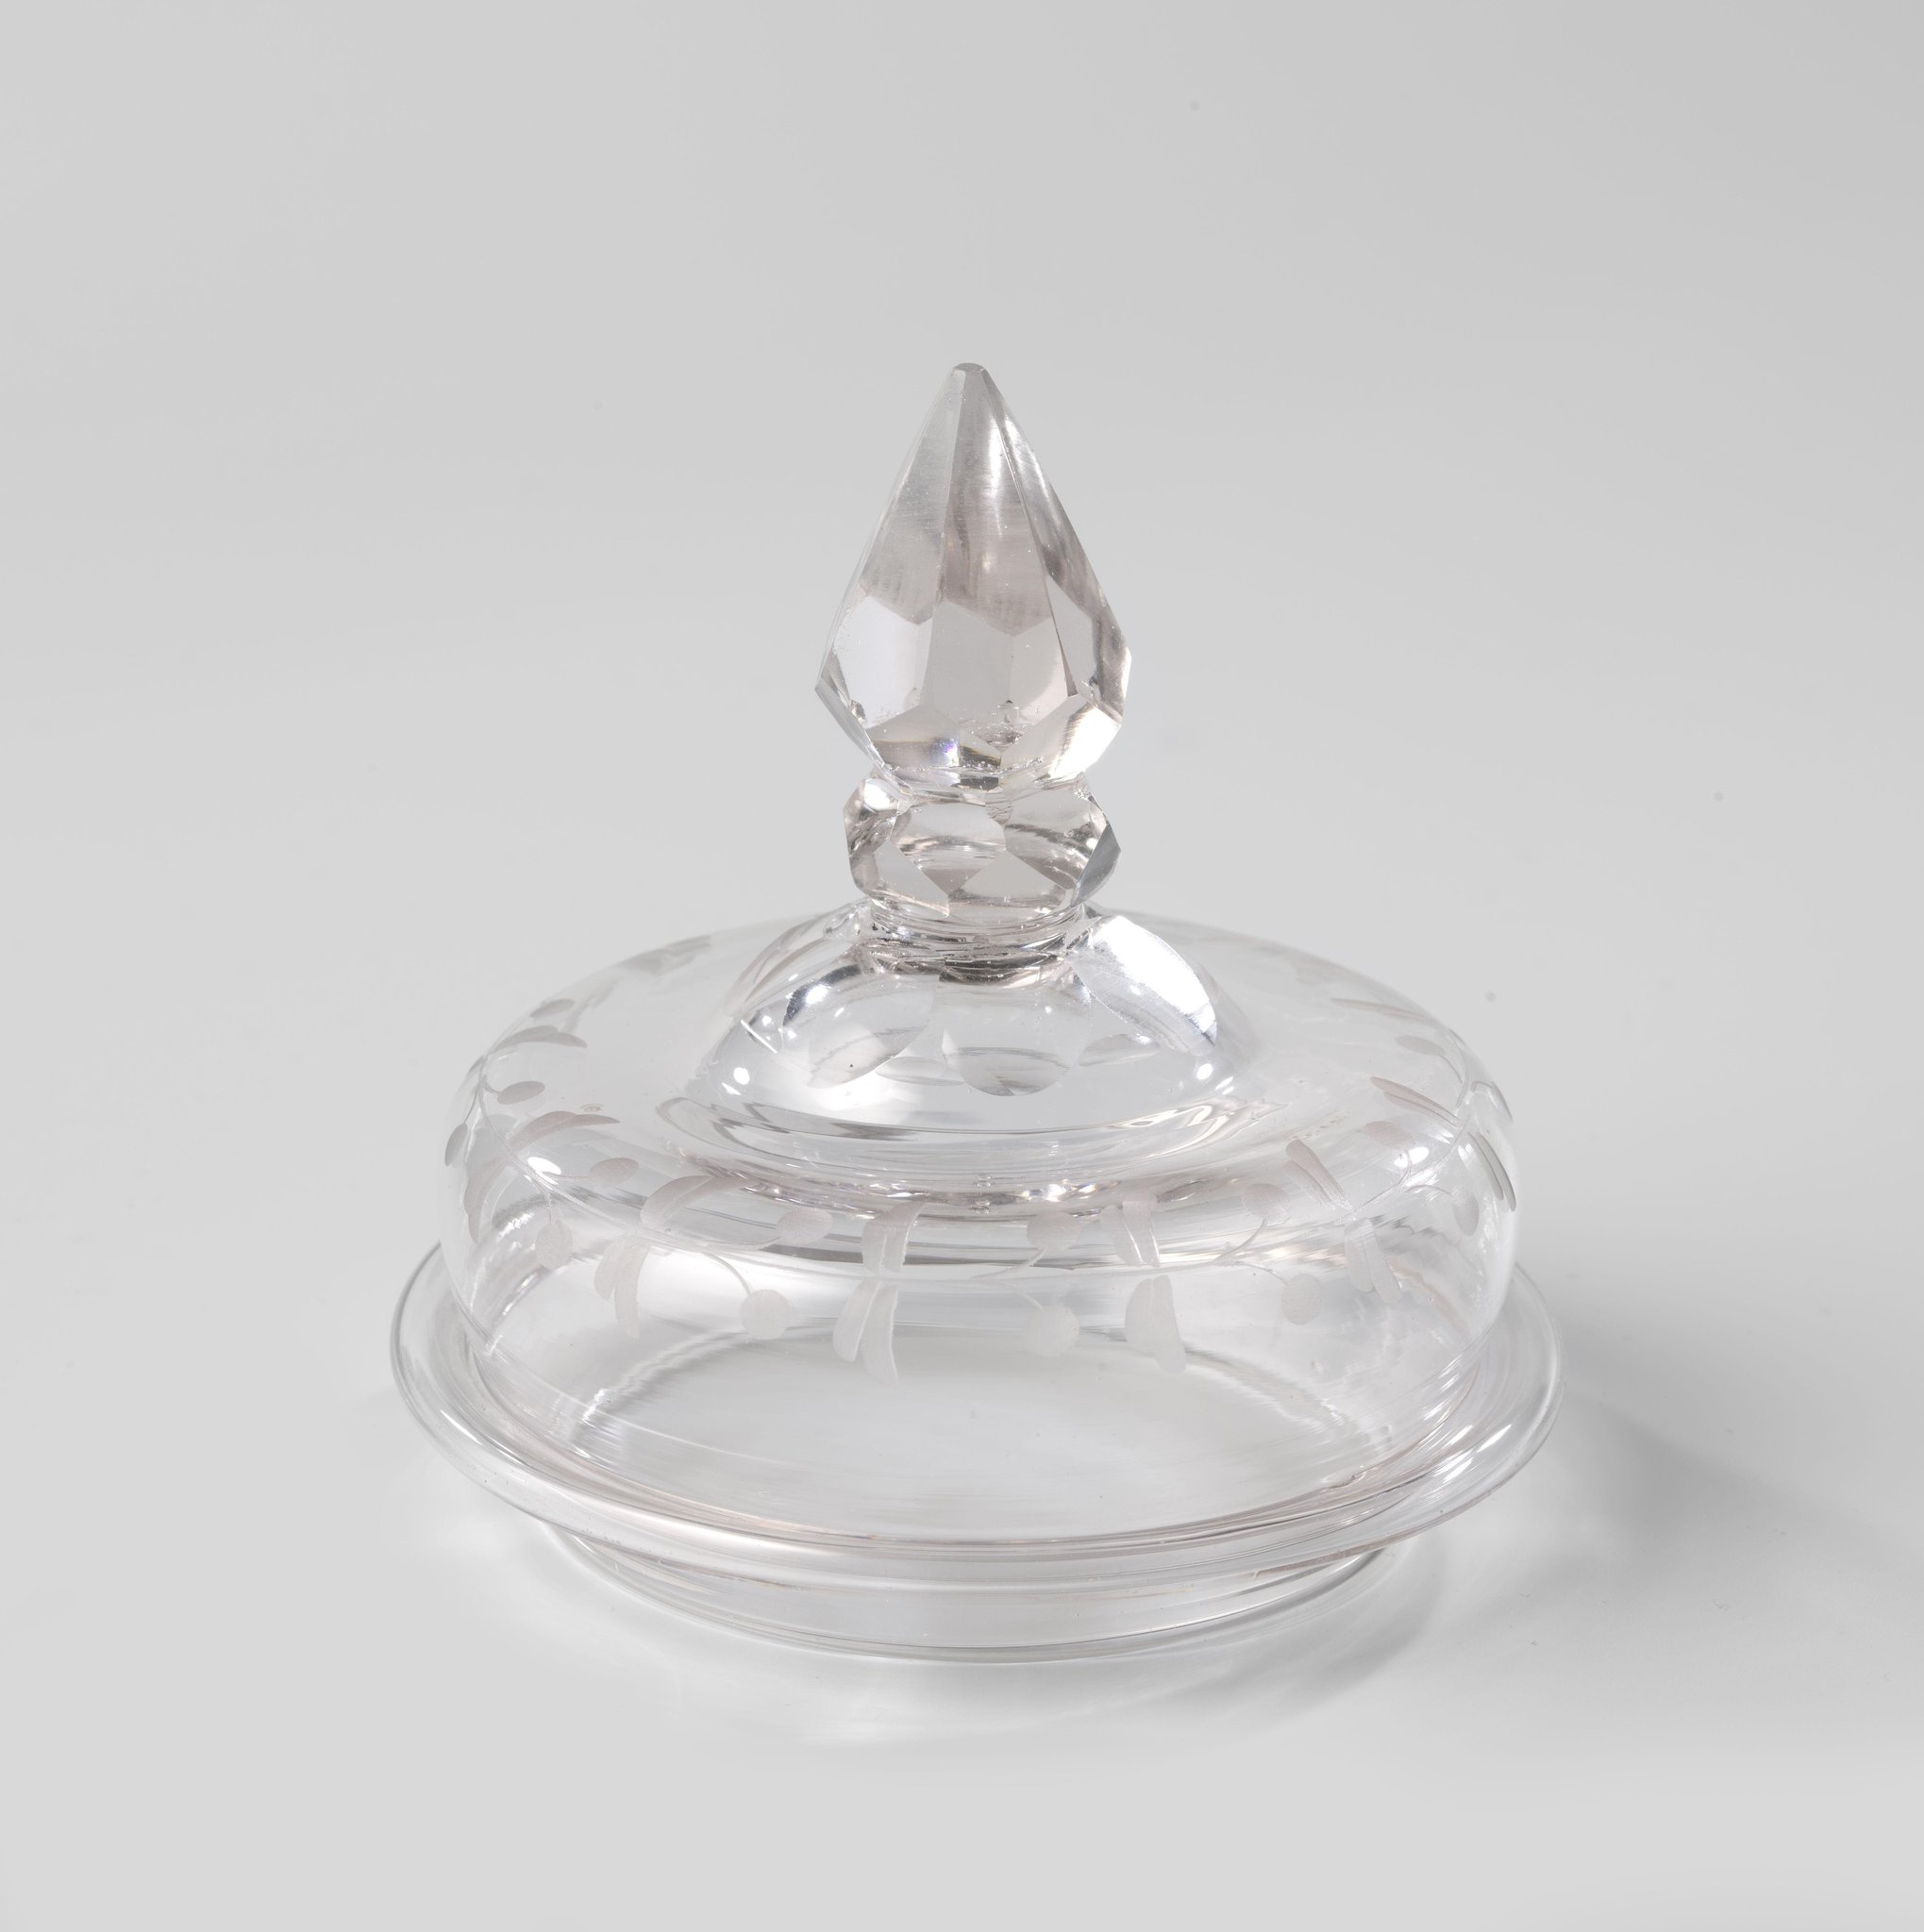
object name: lid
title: Deksel van een bokaal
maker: Anonymous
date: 1725-1750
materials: glass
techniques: glassblowing, grinding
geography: bohemia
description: Gewelfde deksel met koepelvormige verhoging, bekroond met gelede dekselknop, bestaande uit een gefacetteerde knop en een gefacetteerde, peervormige uiteinde. Op de deksel rondlopend een gegraveerde gestileerde bloemslinger.